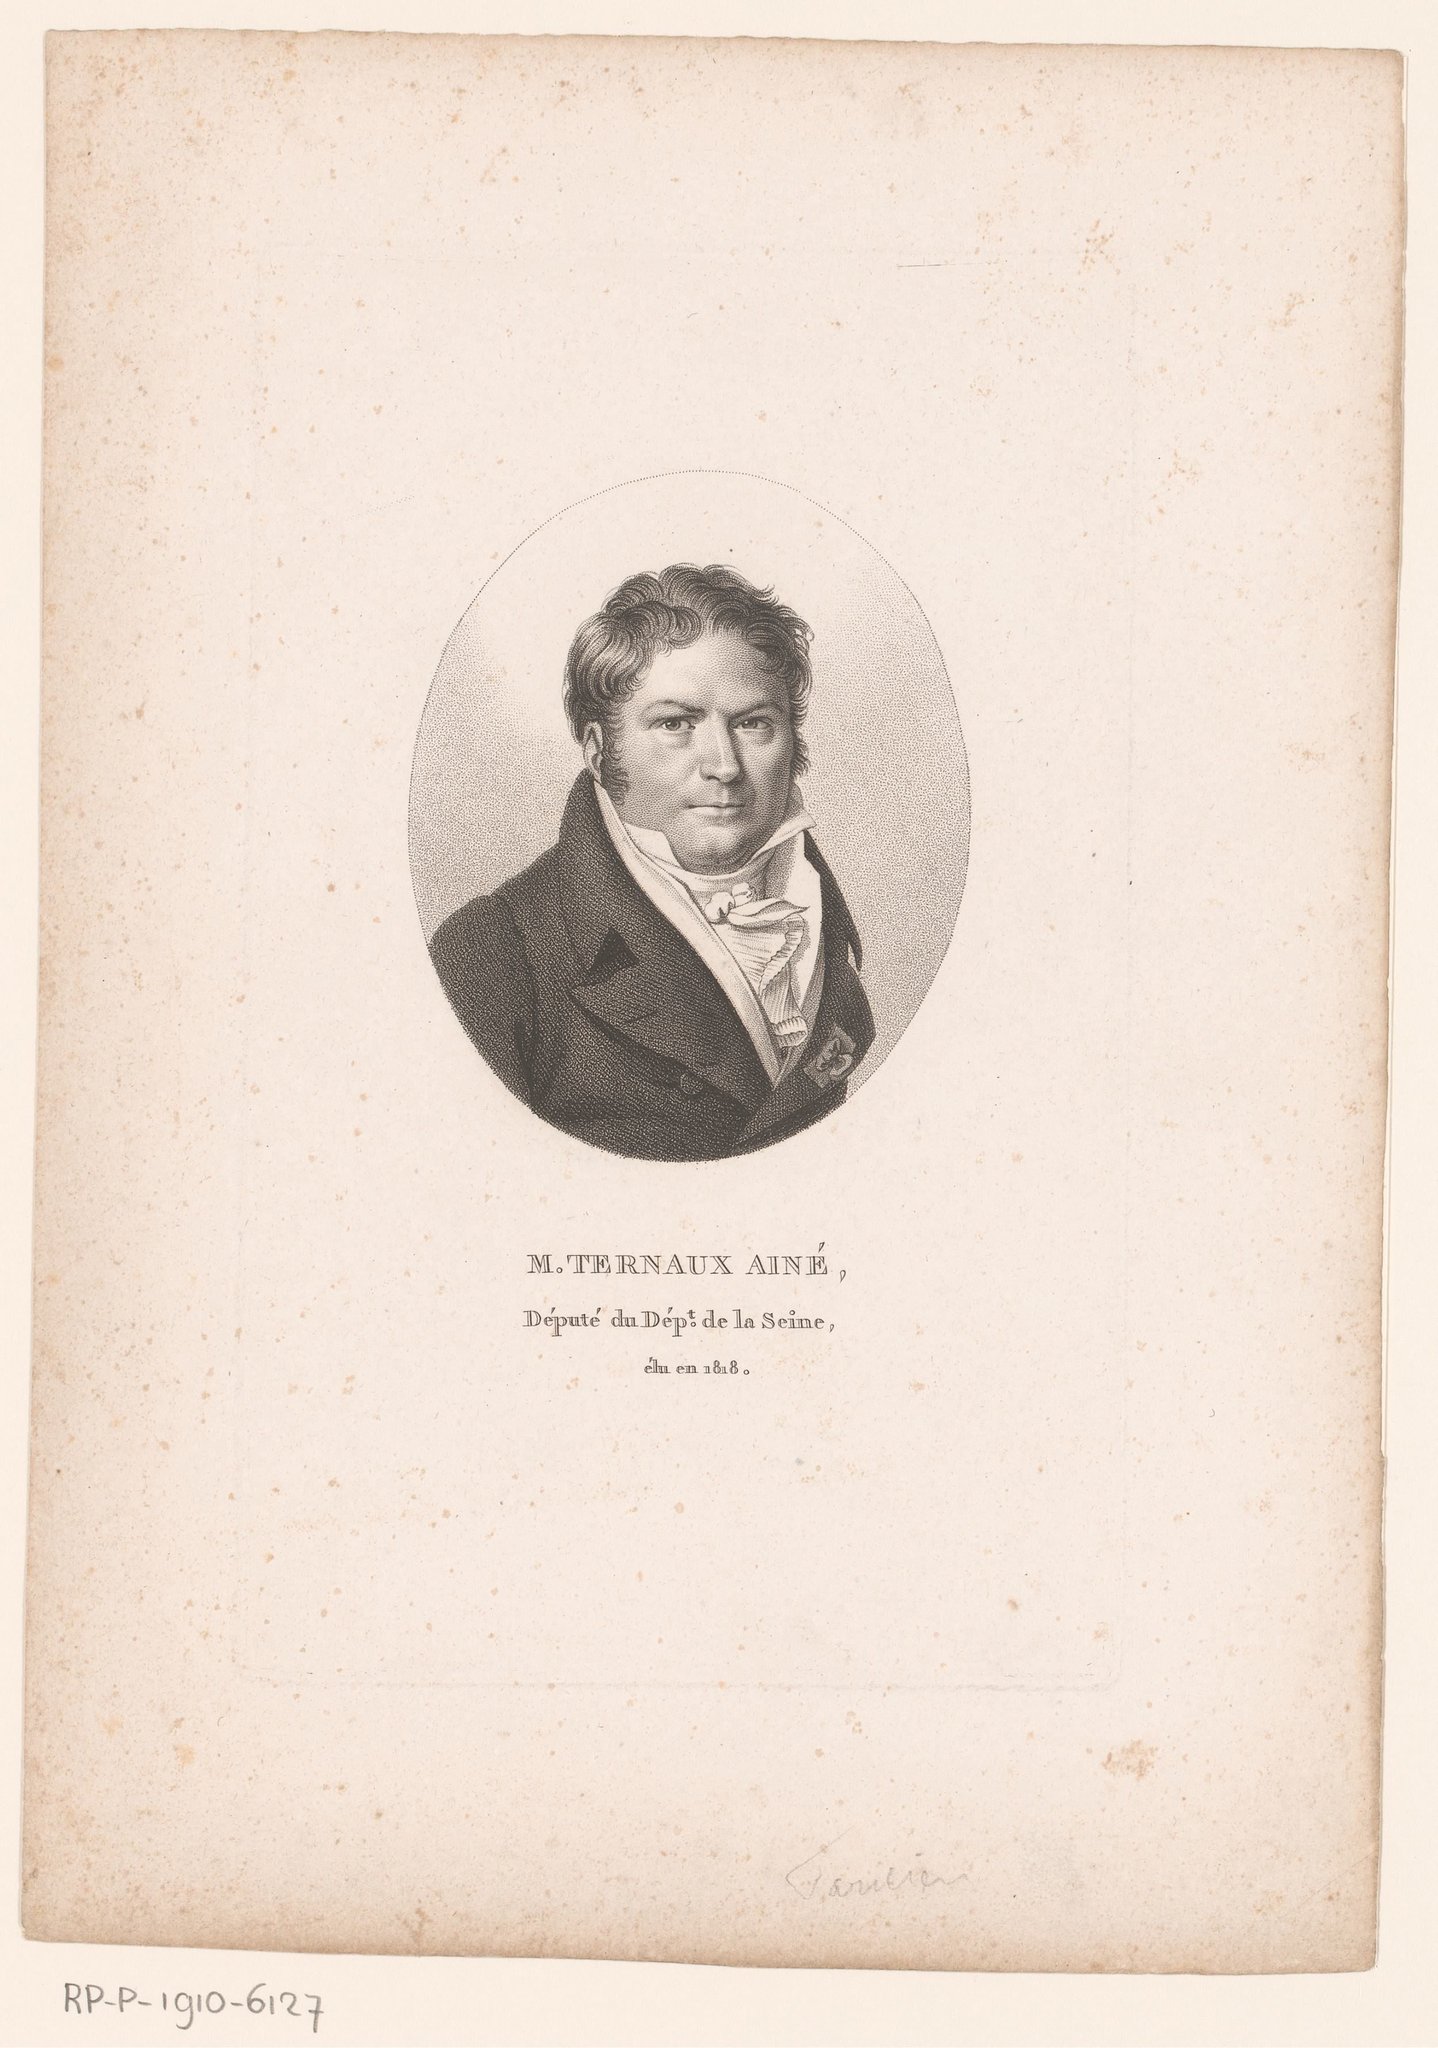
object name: print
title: Portret van Guillaume Louis Ternaux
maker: ambroise tardieu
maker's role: print maker, printer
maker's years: 1788-1841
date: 1820-1821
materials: paper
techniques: engraving, roulette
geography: paris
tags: politician, historical persons, politician, e.g. party leader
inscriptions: collector's mark: Lugt 2228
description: Prent uit: Tardieu, Ambroise. Portraits des députés, écrivains et pairs constitutionnels, défenseurs invariables de la charte et de la loi des élections du 5 février 1817. Parijs: Tardieu, Ambroise, 1820-1821.